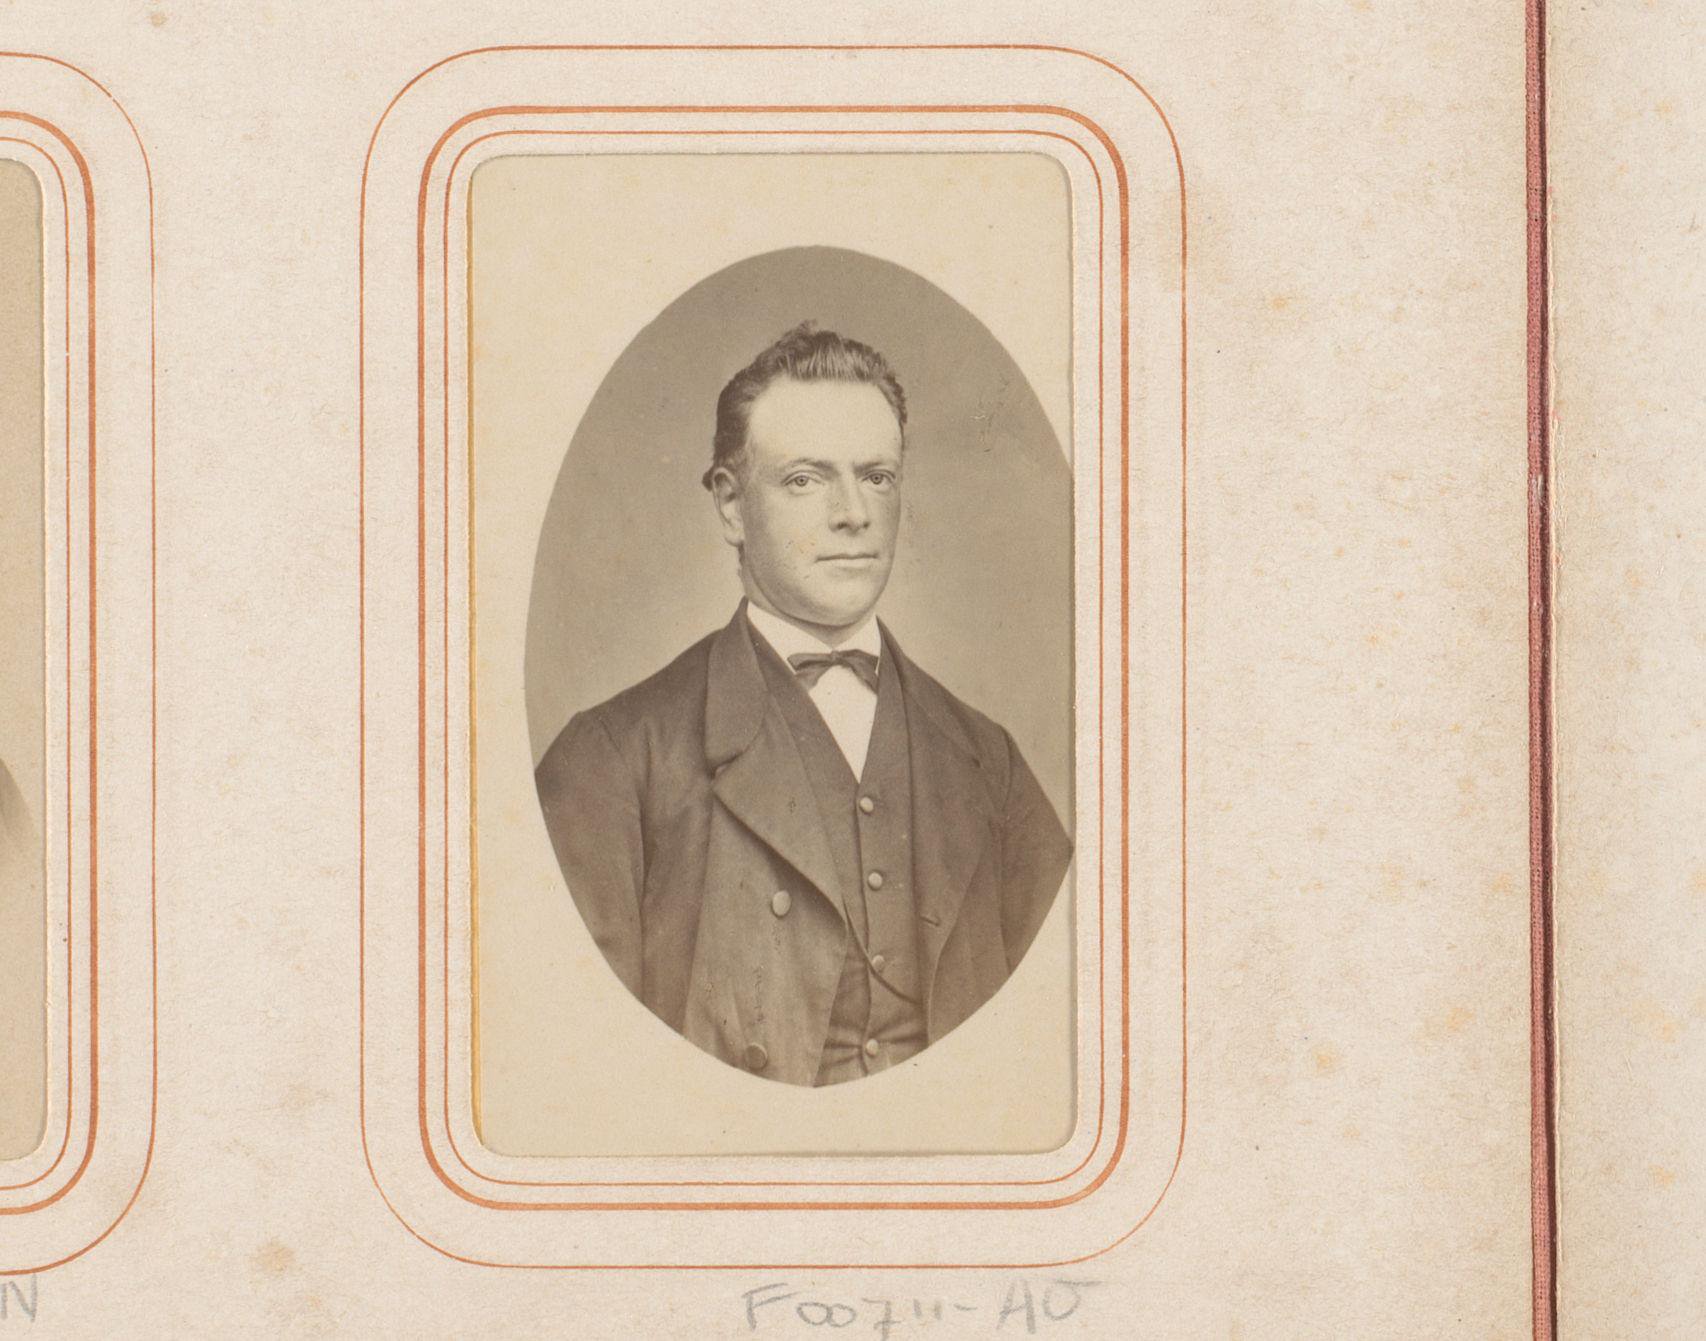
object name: carte de visite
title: Portret van een man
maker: benjamin van der heide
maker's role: fotograaf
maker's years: 1837-1928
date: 1870-1900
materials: cardboard, photographic support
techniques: albumen print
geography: harlingen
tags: historical persons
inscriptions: inscription: ‘Photgrpahie van B. van der Heide/ Harlingen/ Bekroond op de Tentoonstelling van Nijverheid/ te Harlingen 1871’